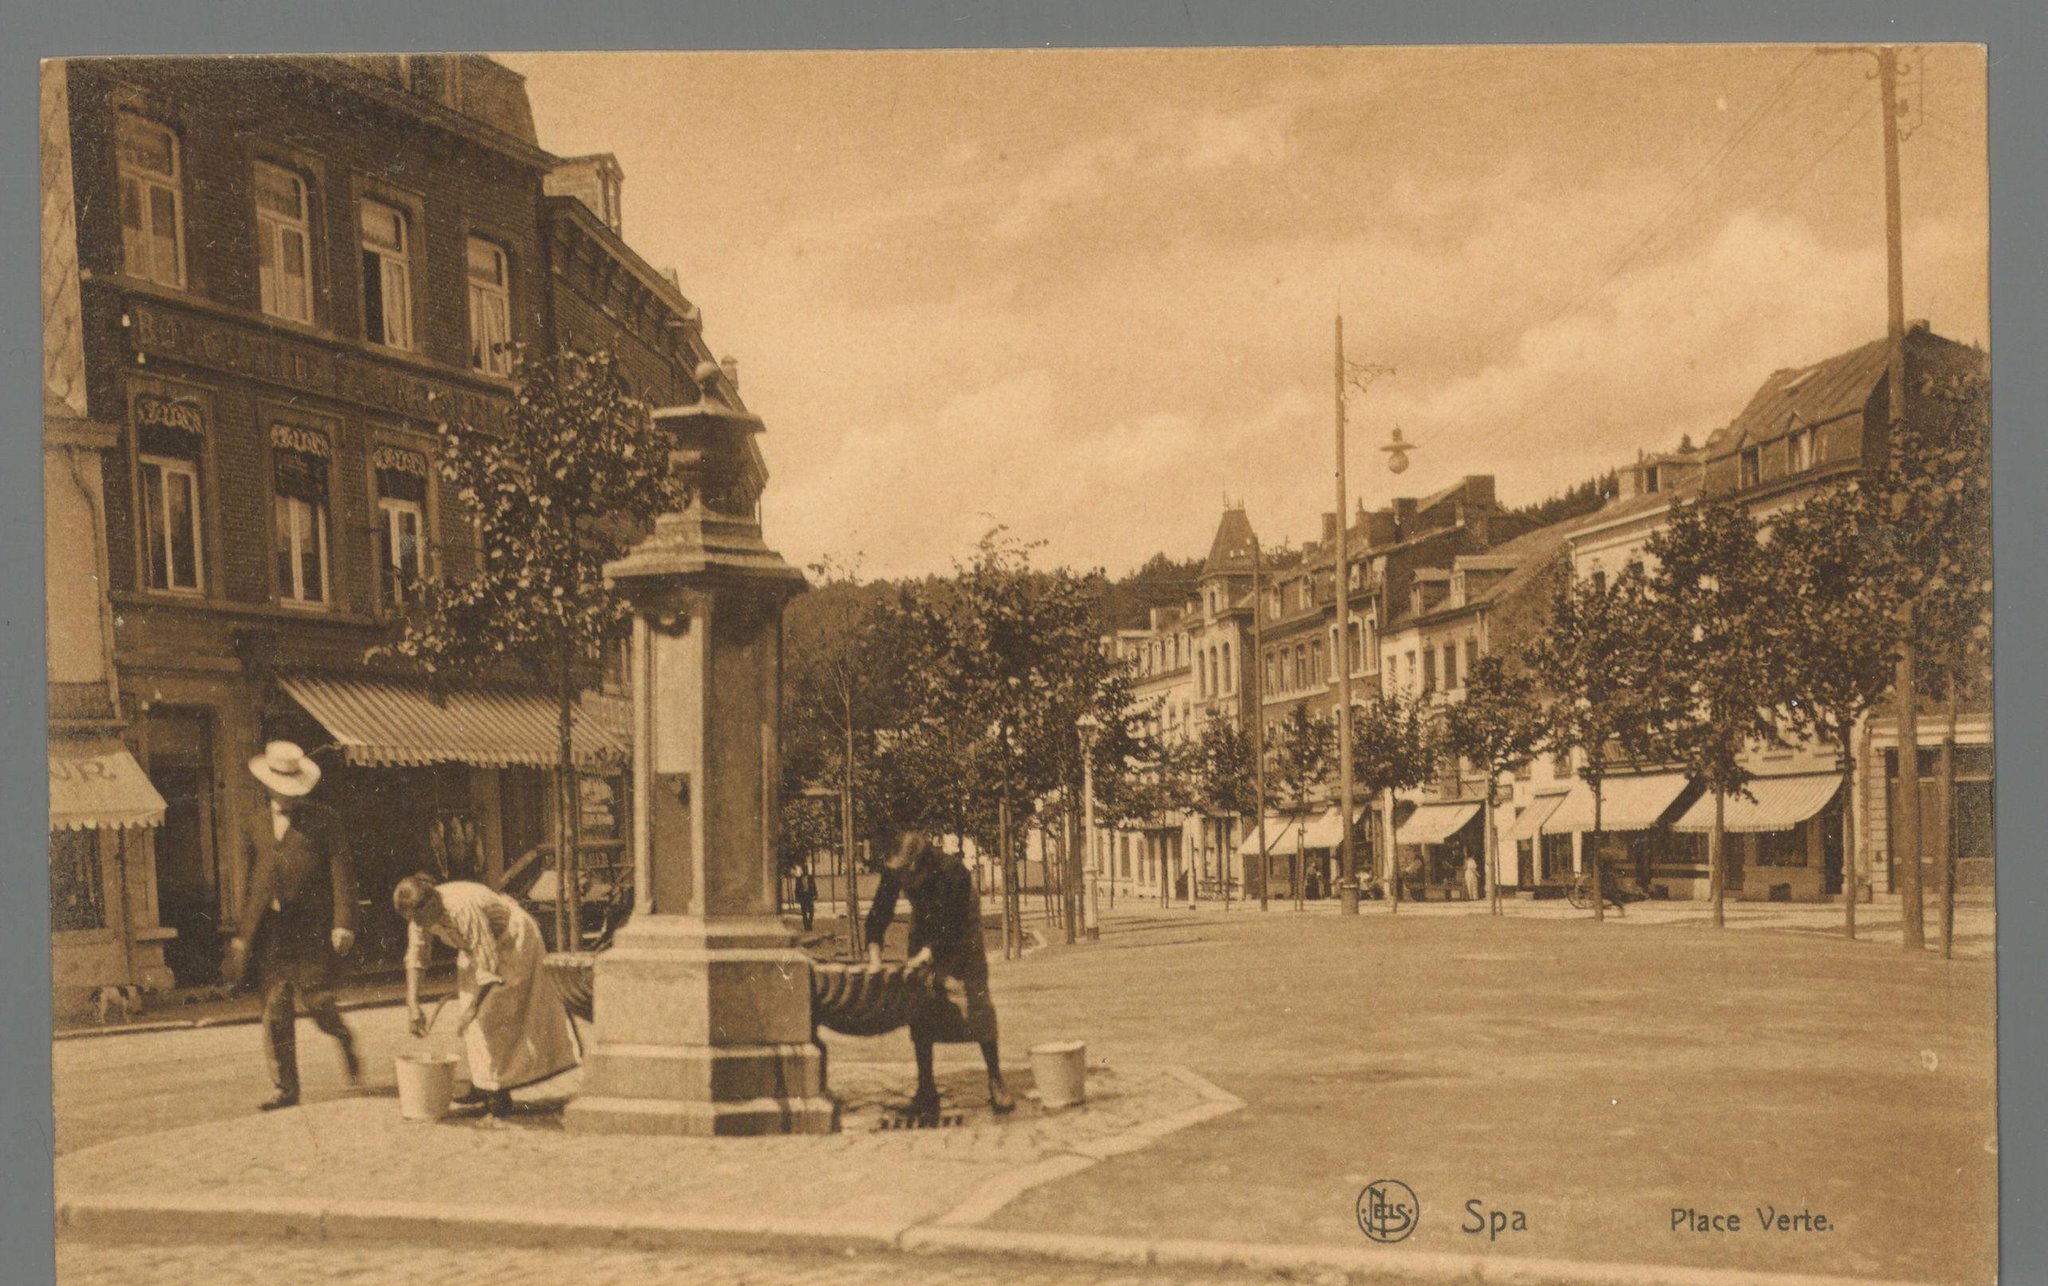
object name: ansichtkaart, prentbriefkaart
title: Spa. Place Verte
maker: Anonymous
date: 1907-1913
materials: cardboard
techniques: photograph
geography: spa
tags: city-view, and landscape with man-made constructions, utilitarian, public pump or water fountain